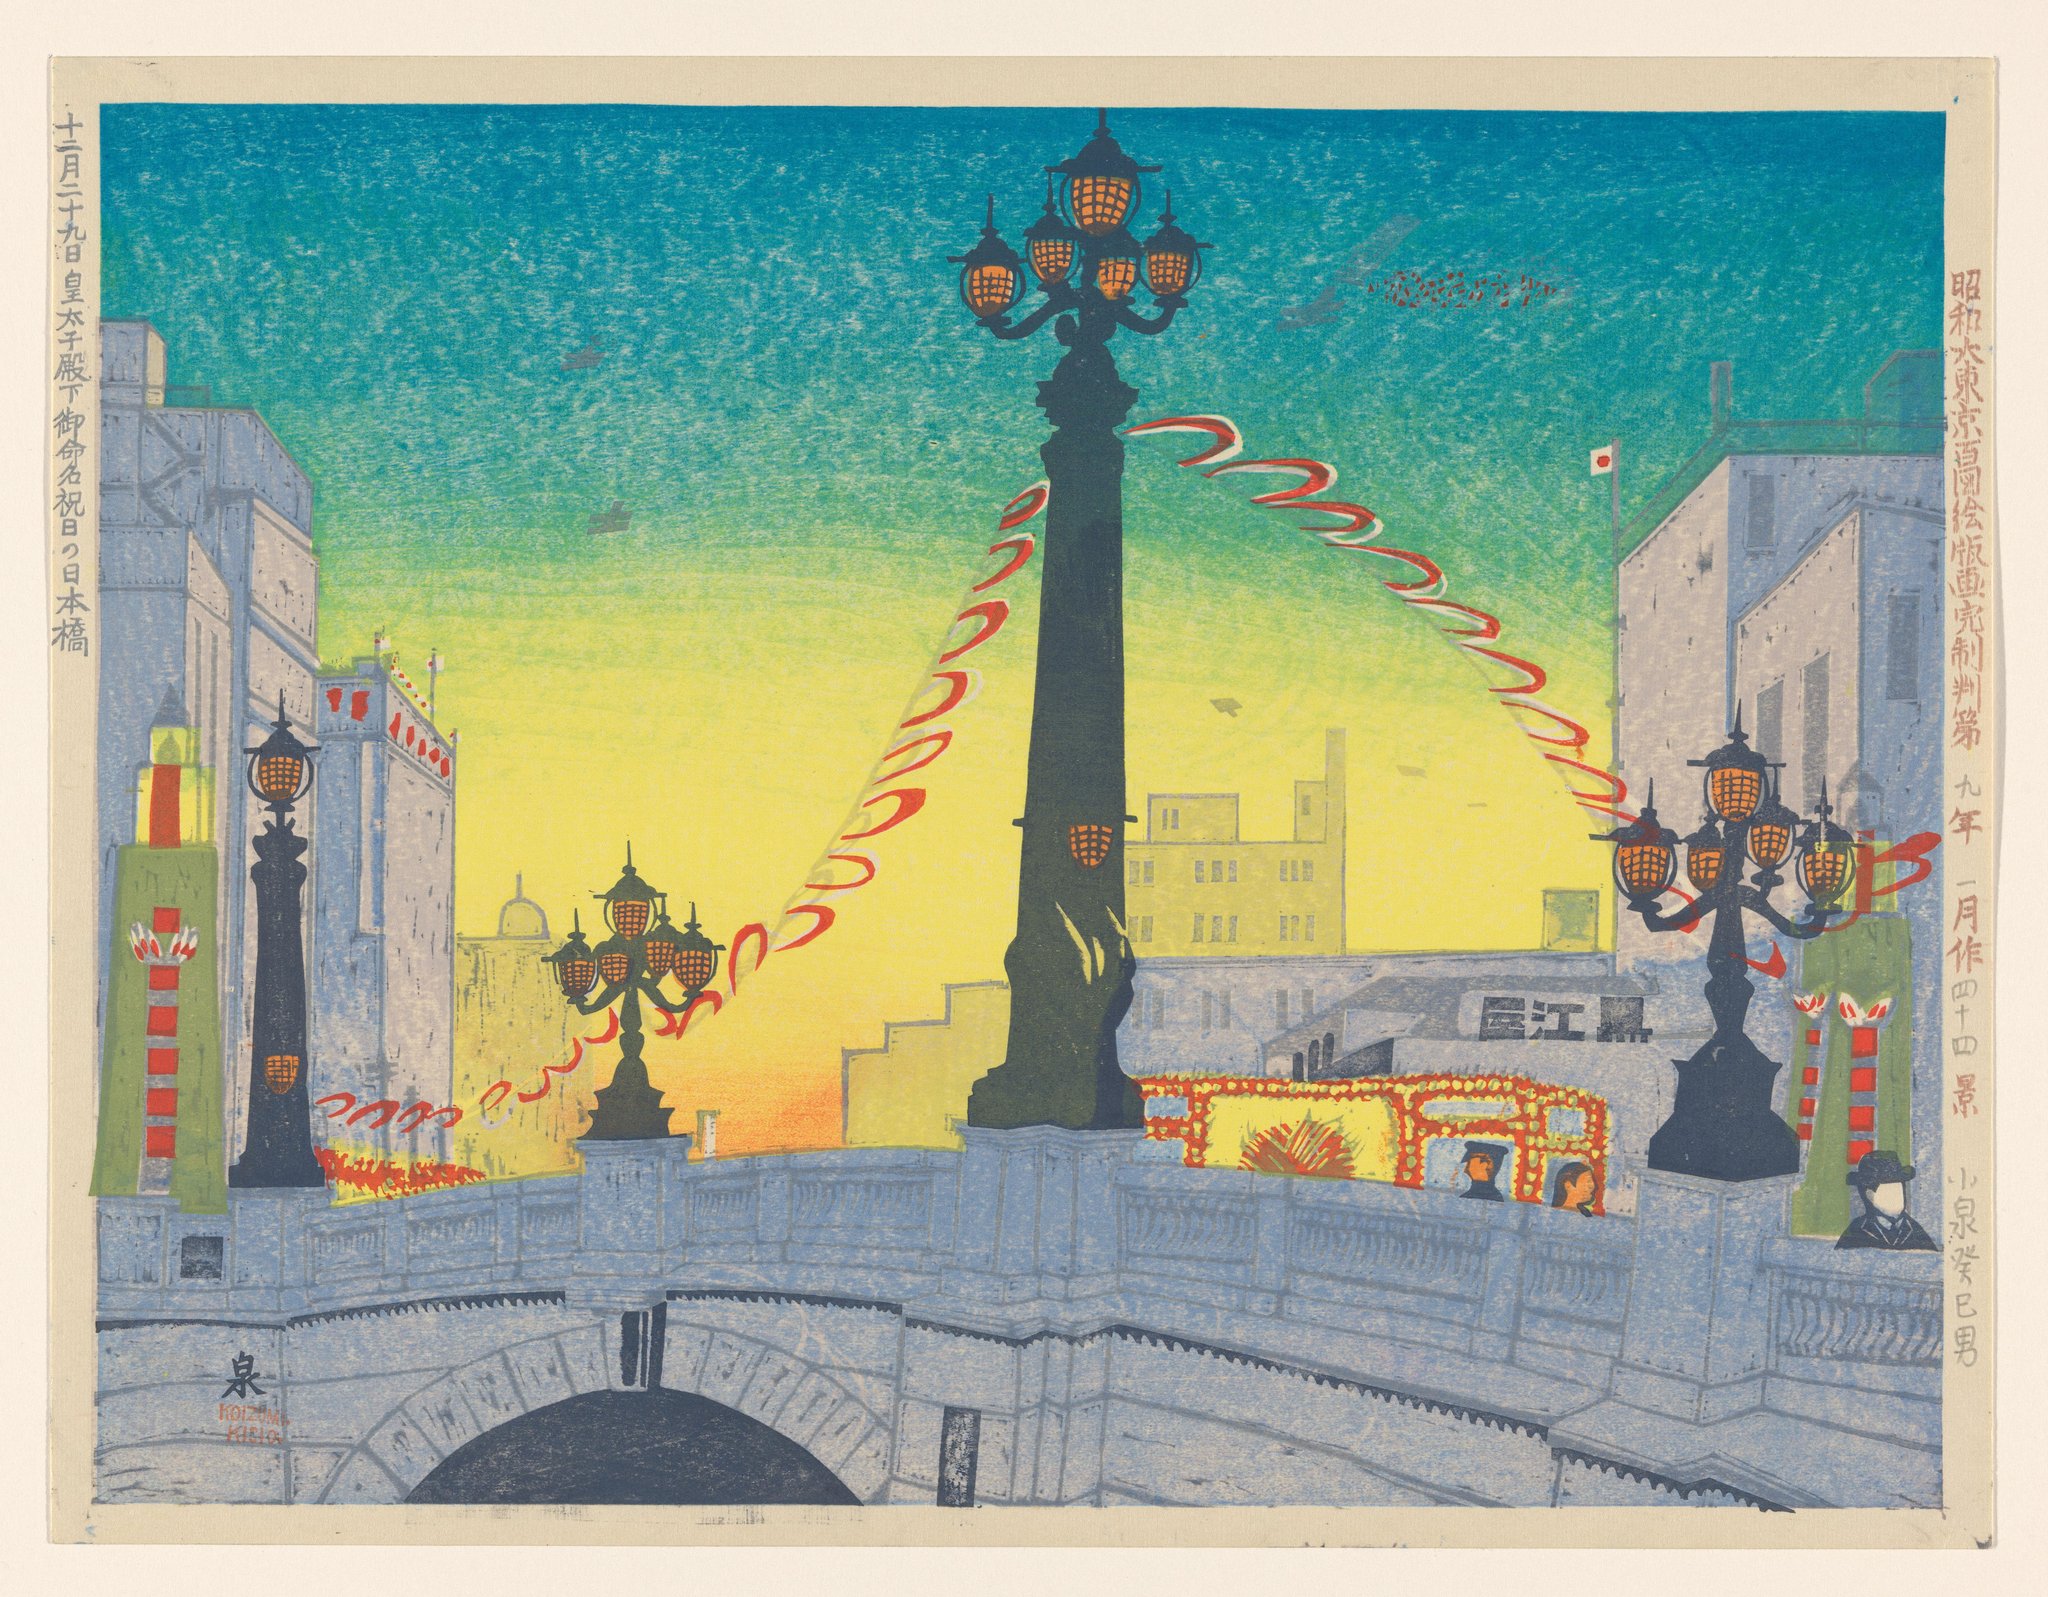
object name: print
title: Jūnigatsu nijūkunichi Kōtaishidenka gomeimei shukujitsu no Nihonbashi yonjūyonkei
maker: koizumi kishio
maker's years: 1893-1945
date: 1901-1934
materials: paper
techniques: woodcut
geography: japan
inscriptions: signature: ‘泉’, seal: ‘Koizumi Kisio.’, signature: ‘小泉癸巳男’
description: Rood-witte slingers hangen tussen de lantaarns van Nihonbashi, de 'Japanbrug' in hartje Tokyo. In januari 1934 vierde Japan de geboorte van de kroonprins Akihito, die op 23 december 1933 werd geboren. Hij zou zijn vader Hirohito pas in 1989 opvolgen. In september 1928 begon Koizumi Kishio aan zijn ambitieuze plan om honderd landschapsprenten met scènes in Tokyo volledig zelf te ontwerpen, hiervan zelf de drukblokken te snijden en zelf de prenten te drukken. De aanleiding voor het project was grote verandering die Tokyo onderging door de verwoestende Grote Kantō-aardbeving van 1923 en de wederopbouw die daarop volgde. Kishio maakt een bewuste verwijzing naar de bekende serie ‘Honderd beroemde gezichten op Edo’ door Utagawa Hiroshige (1797–1858), met prenten van locaties in Edo—de oude benaming voor Tokyo. Kishio toont overwegend moderne gebouwen, instituten en mensen die de tijdsgeest van de jaren 1920 en 1930 weerspiegelen. Sommige prenten onthullen daarentegen een nostalgische blik op overblijfselen uit het oude Edo. Kishio verkocht de prenten aan de hand van een abonnement met een limiet van vijftig leden, die elke maand een of twee prenten zouden ontvangen. Het project begon met negen abonnementen, maar al na de tweede maand werden meerdere daarvan opgezegd en slechts vier mecenassen bleven lid tot en met de voltooiing van de serie. Hij bracht het honderdste ontwerp uit in 1937. Zijn leermeester Ishii Hakutei schreef een inleiding in 1938 die Kishio verwerkte tot een prent en toevoegde aan de set. Tussen 1939 en 1940 maakte hij nog eens negen extra ontwerpen. Met acht van deze ontwerpen verving hij oudere nummers uit de serie, mogelijk omdat hij niet tevreden was met de composities. Uiteindelijk lukte het Kishio om tien complete sets te verkopen aan de shin hanga-uitgever Watanabe Shōzaburō en liet hiervoor speciale houten dozen maken. Deze prent behoort tot een van die tien sets.